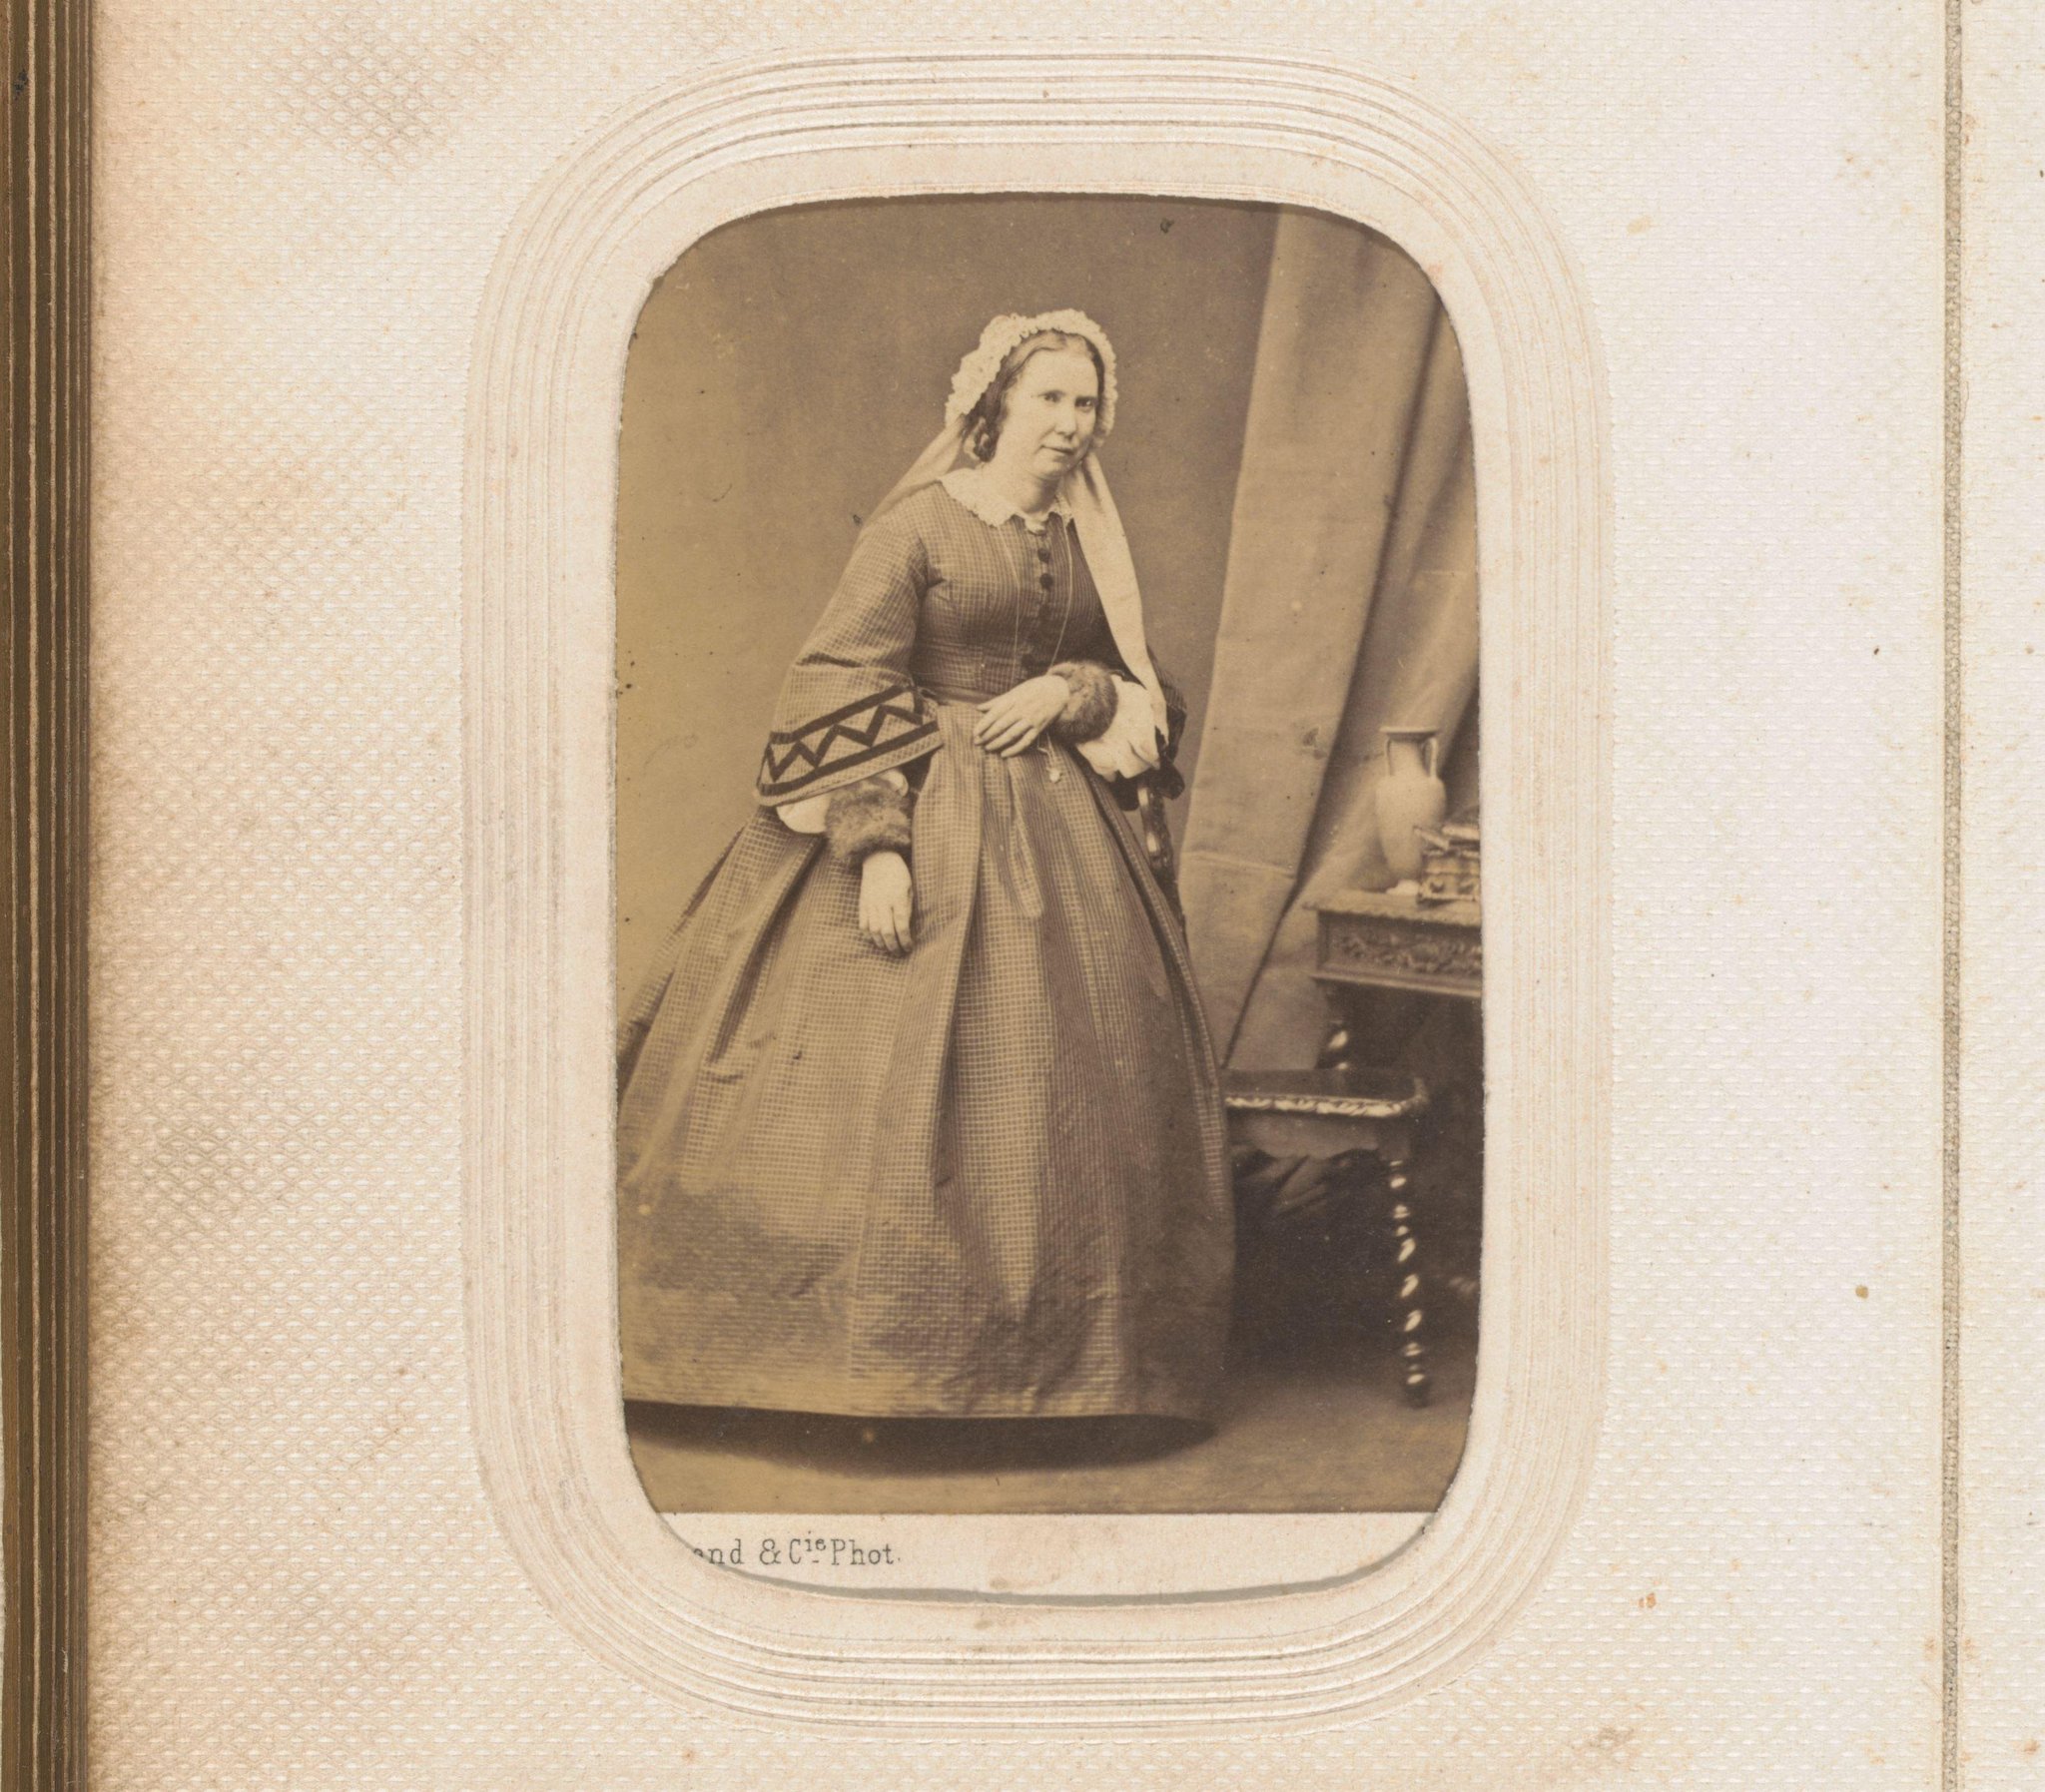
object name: photograph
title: Portret van een staande vrouw met witte muts met linten, bij een kruk en tafeltje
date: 1860-1870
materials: cardboard, photographic support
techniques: albumen print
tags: adult woman, historical persons, head-gear: cap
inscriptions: inscription: ‘Bordeaux’